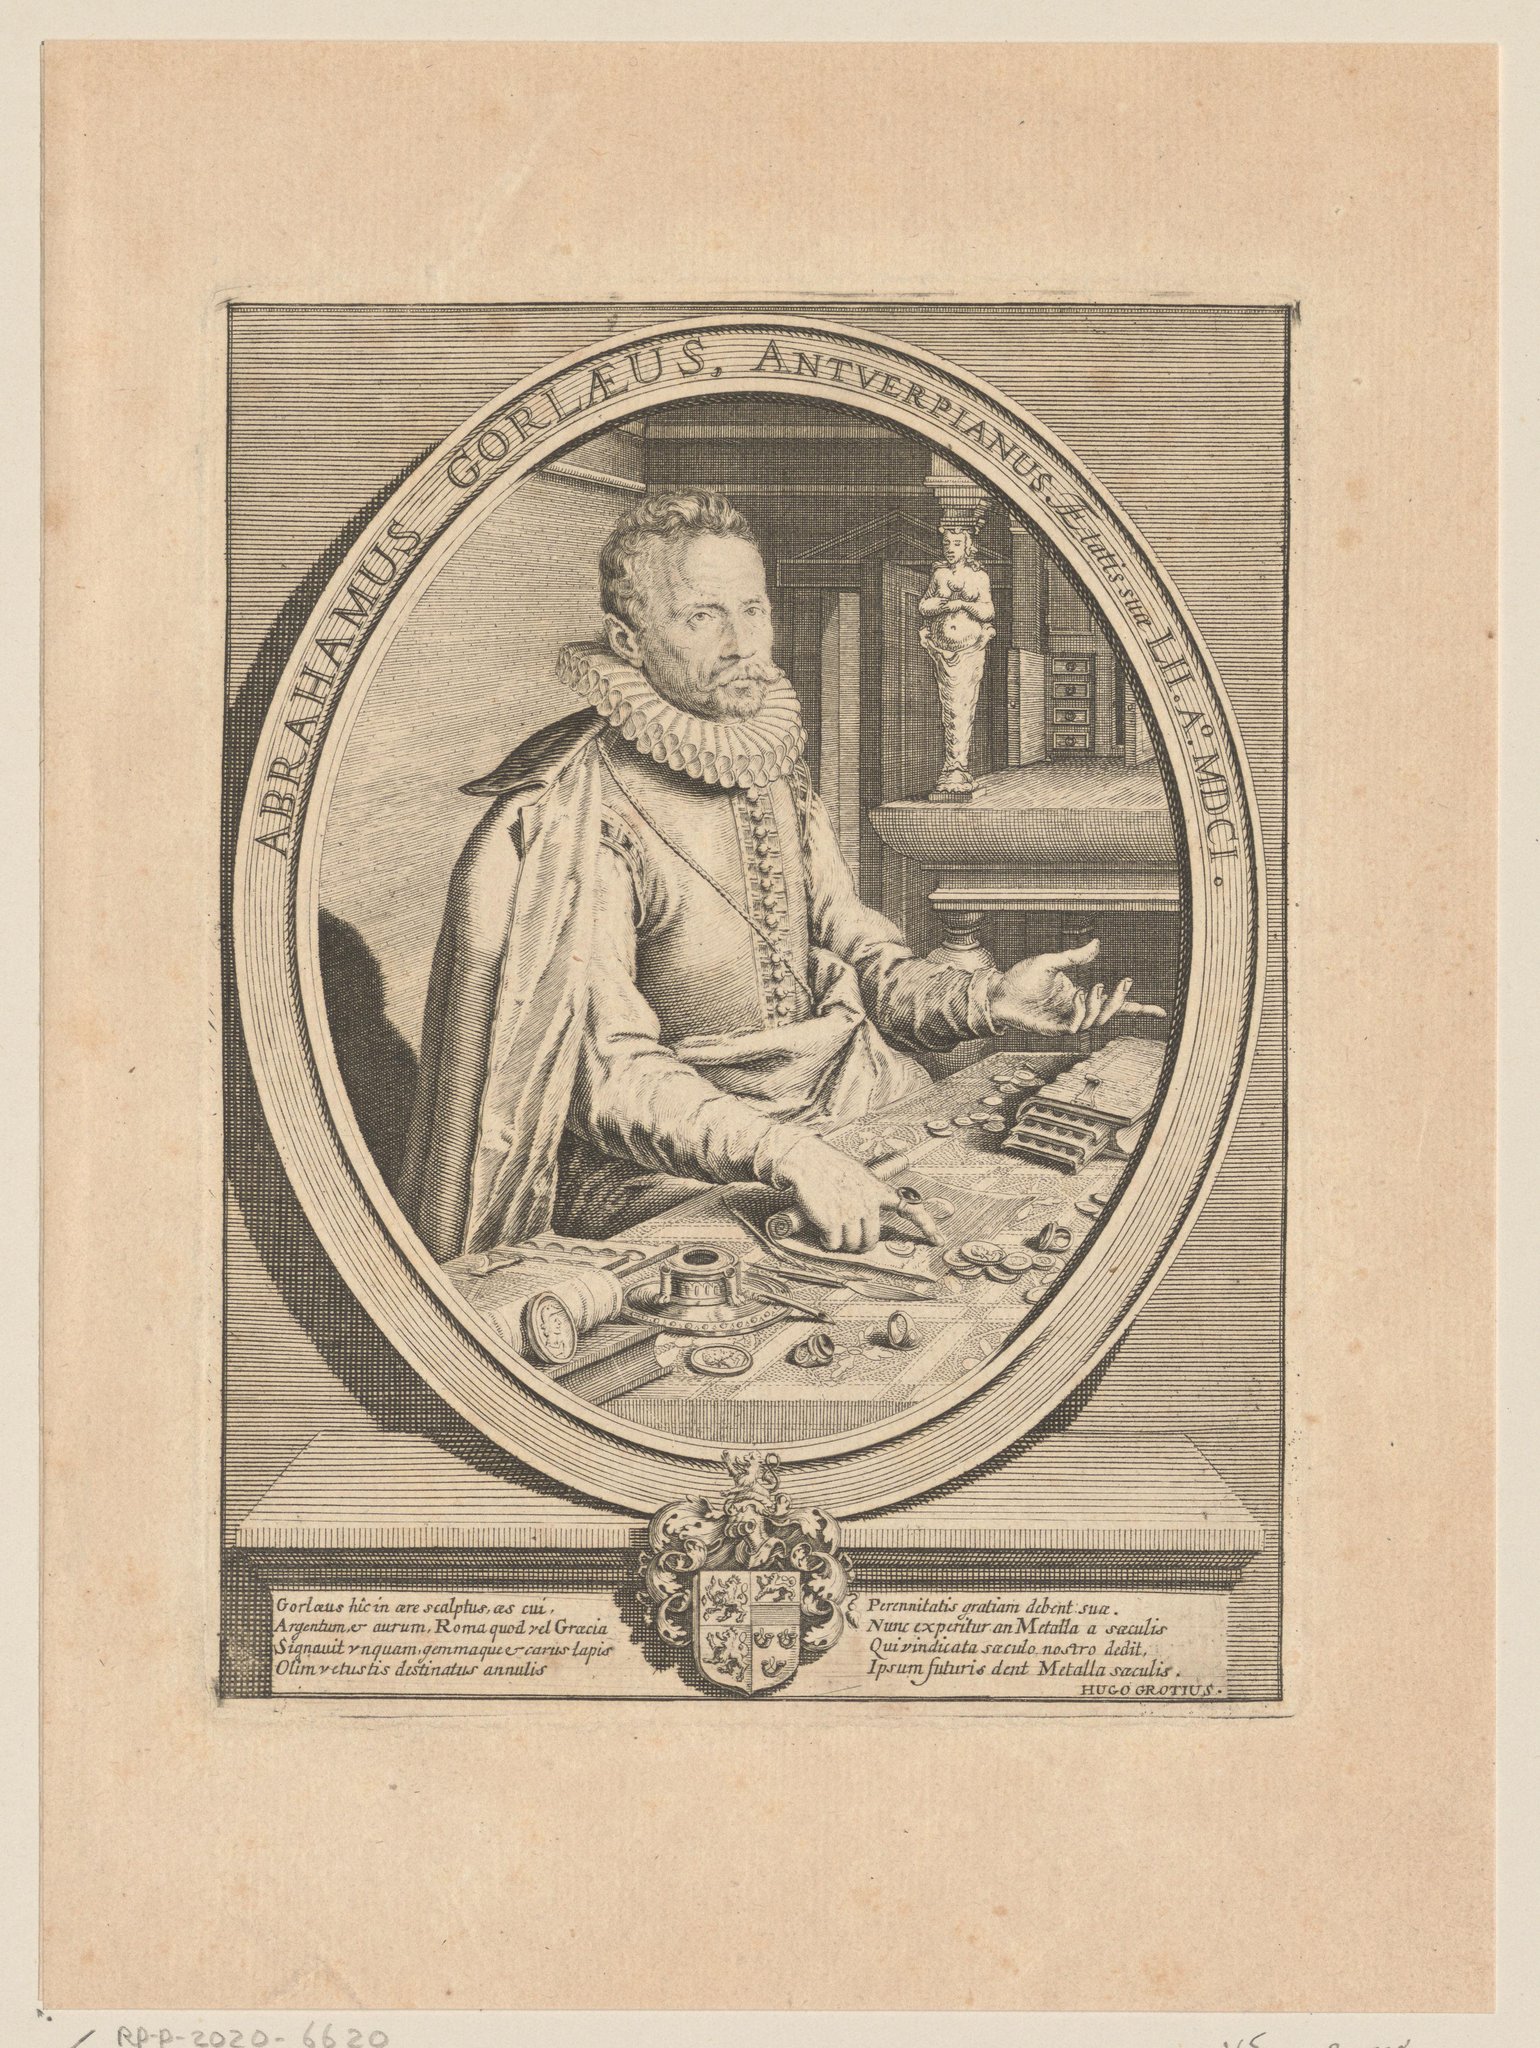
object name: print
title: Portret van Abraham Gorlaeus op 52-jarige leeftijd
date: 1675-1700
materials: paper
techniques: engraving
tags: antwerp, delft, 'kunstschrank', historical persons, art collector, medal (considered as a piece of sculpture, regardless of its specific function), study; 'studiolo'; library, ring, gem, gemstone, money-chest, treasure-chest, money-box, armorial bearing, heraldry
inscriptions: collector's mark: Lugt 240